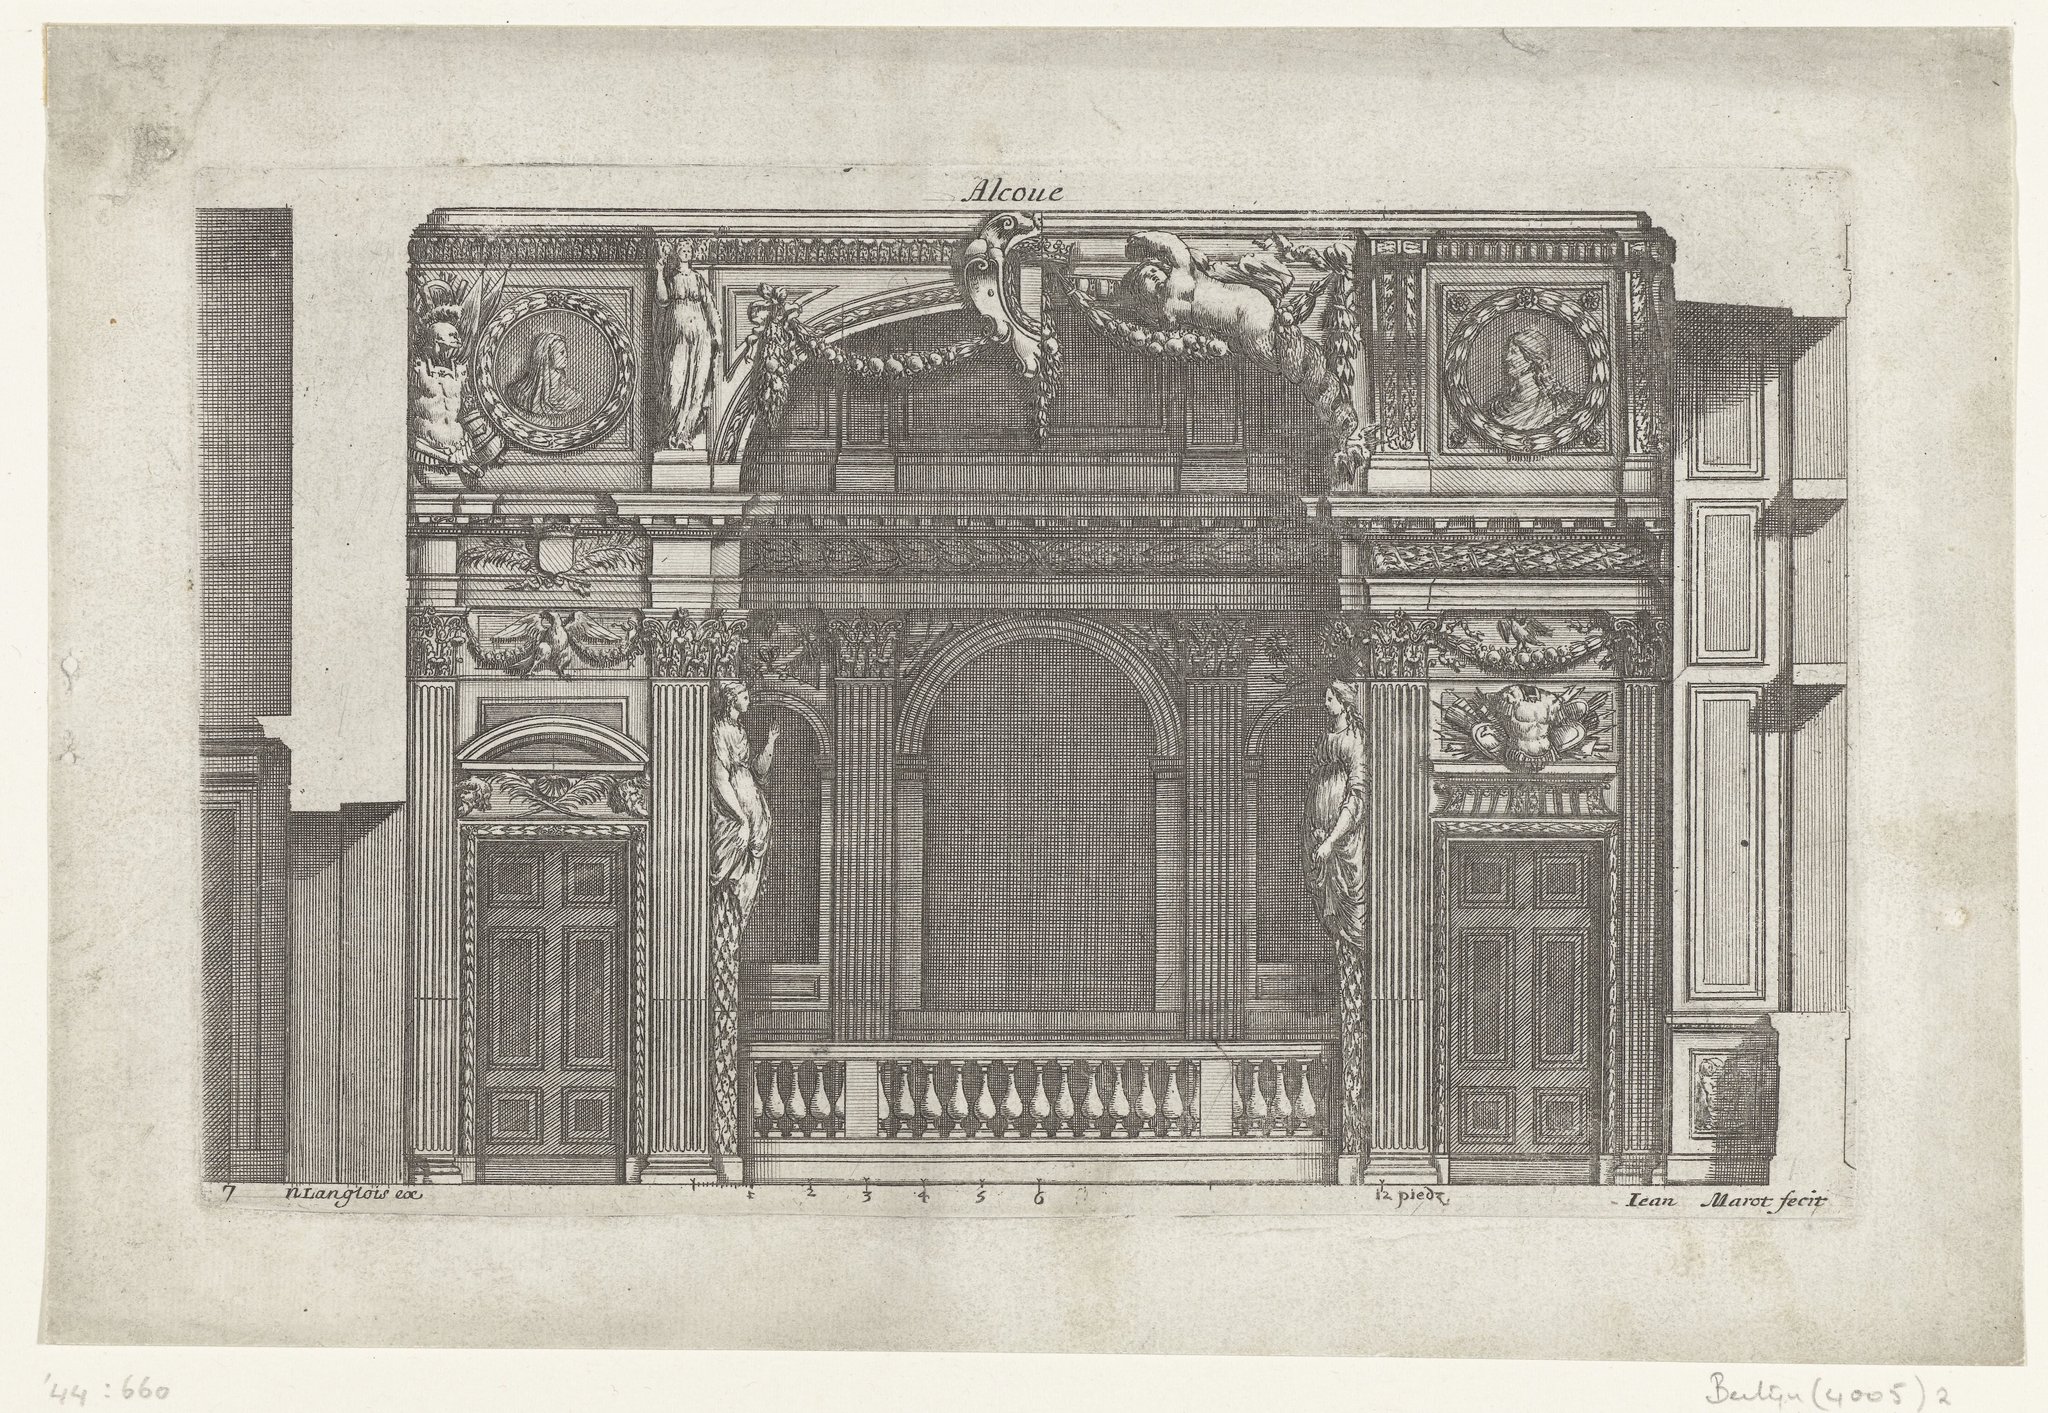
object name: ornament print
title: Muurindeling met Korintische pilasters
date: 1629-1703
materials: paper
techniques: engraving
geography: paris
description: ws. 646, 647, 648 en 650 (ontwerpen voor plafonds) geruild met firma Brandt voorjaar 1970